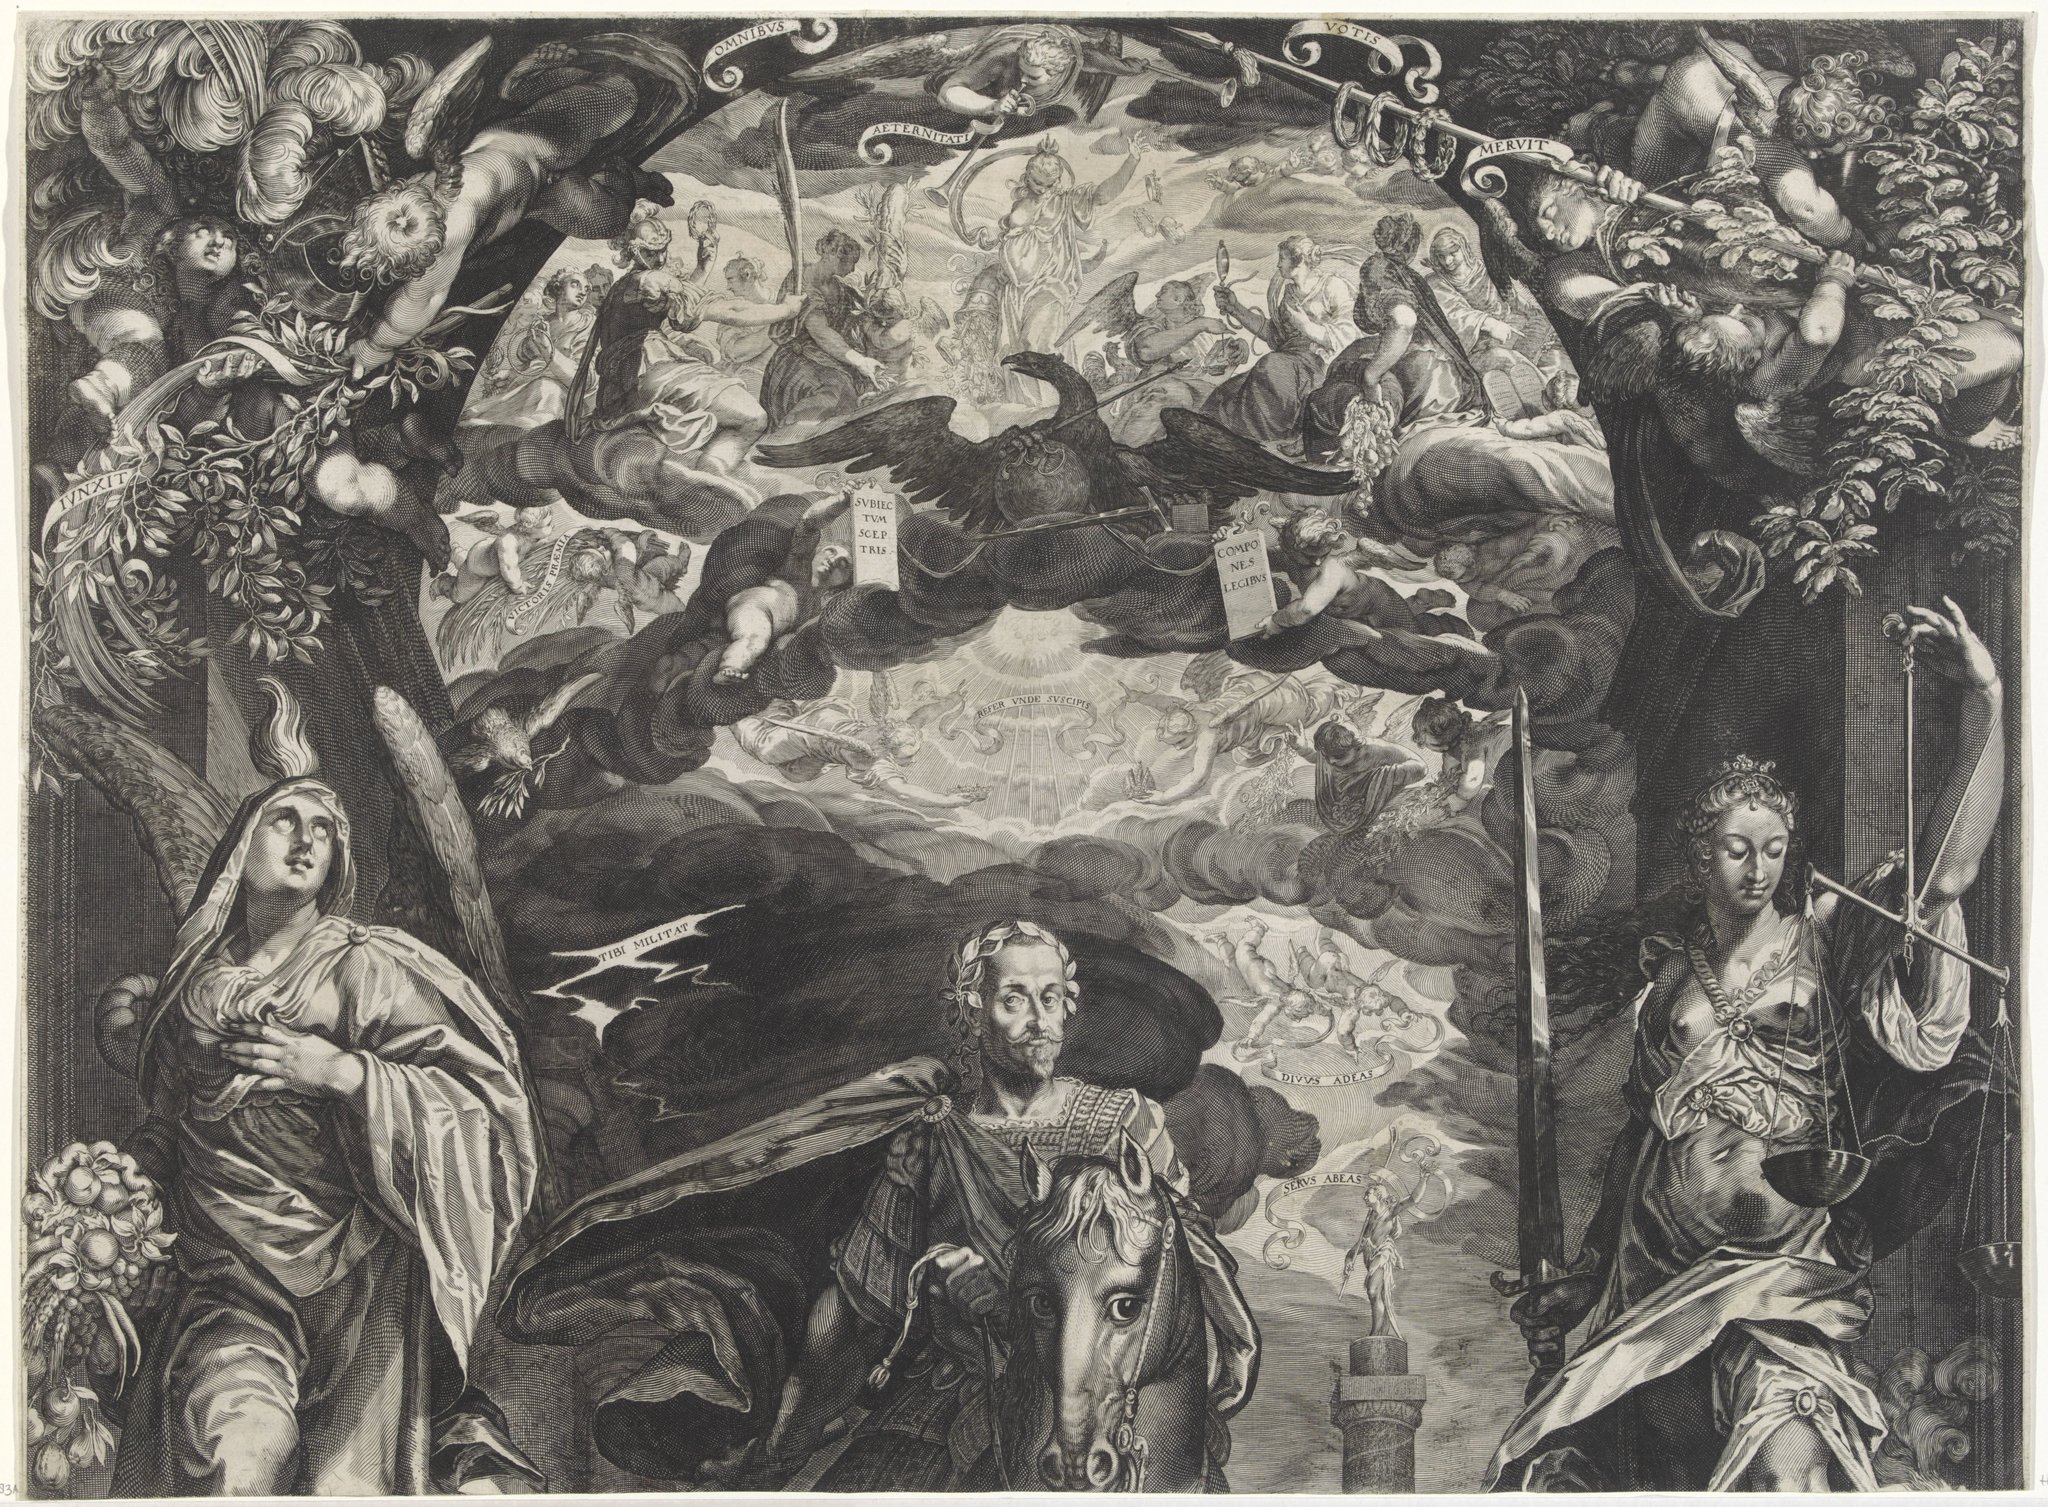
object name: print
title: Keizer Ferdinand II te paard (bovenste blad)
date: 1629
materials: paper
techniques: engraving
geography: prague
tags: vienna, ferdinand ii (duits keizer), equestrian state-portrait, integrity, historical persons, perseverance, resolution, determination; 'perseveranza' (ripa)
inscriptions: collector's mark: Lugt 2228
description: Keizer Ferdinand II zit in Romeinse wapenrusting op een paard. Hij draagt een lauwerkrans. Links staat de gevleugelde personificatie van standvastigheid met een hoorn des overvloeds in haar hand. Rechts de Integriteit met dezelfde attributen als Justitia. Boven hen verschillende putti met lauriertakken, stenen tafelen en spreukbanden. Midden boven een adelaar voor Fortuna(?) en enkele andere allegorische figuren.